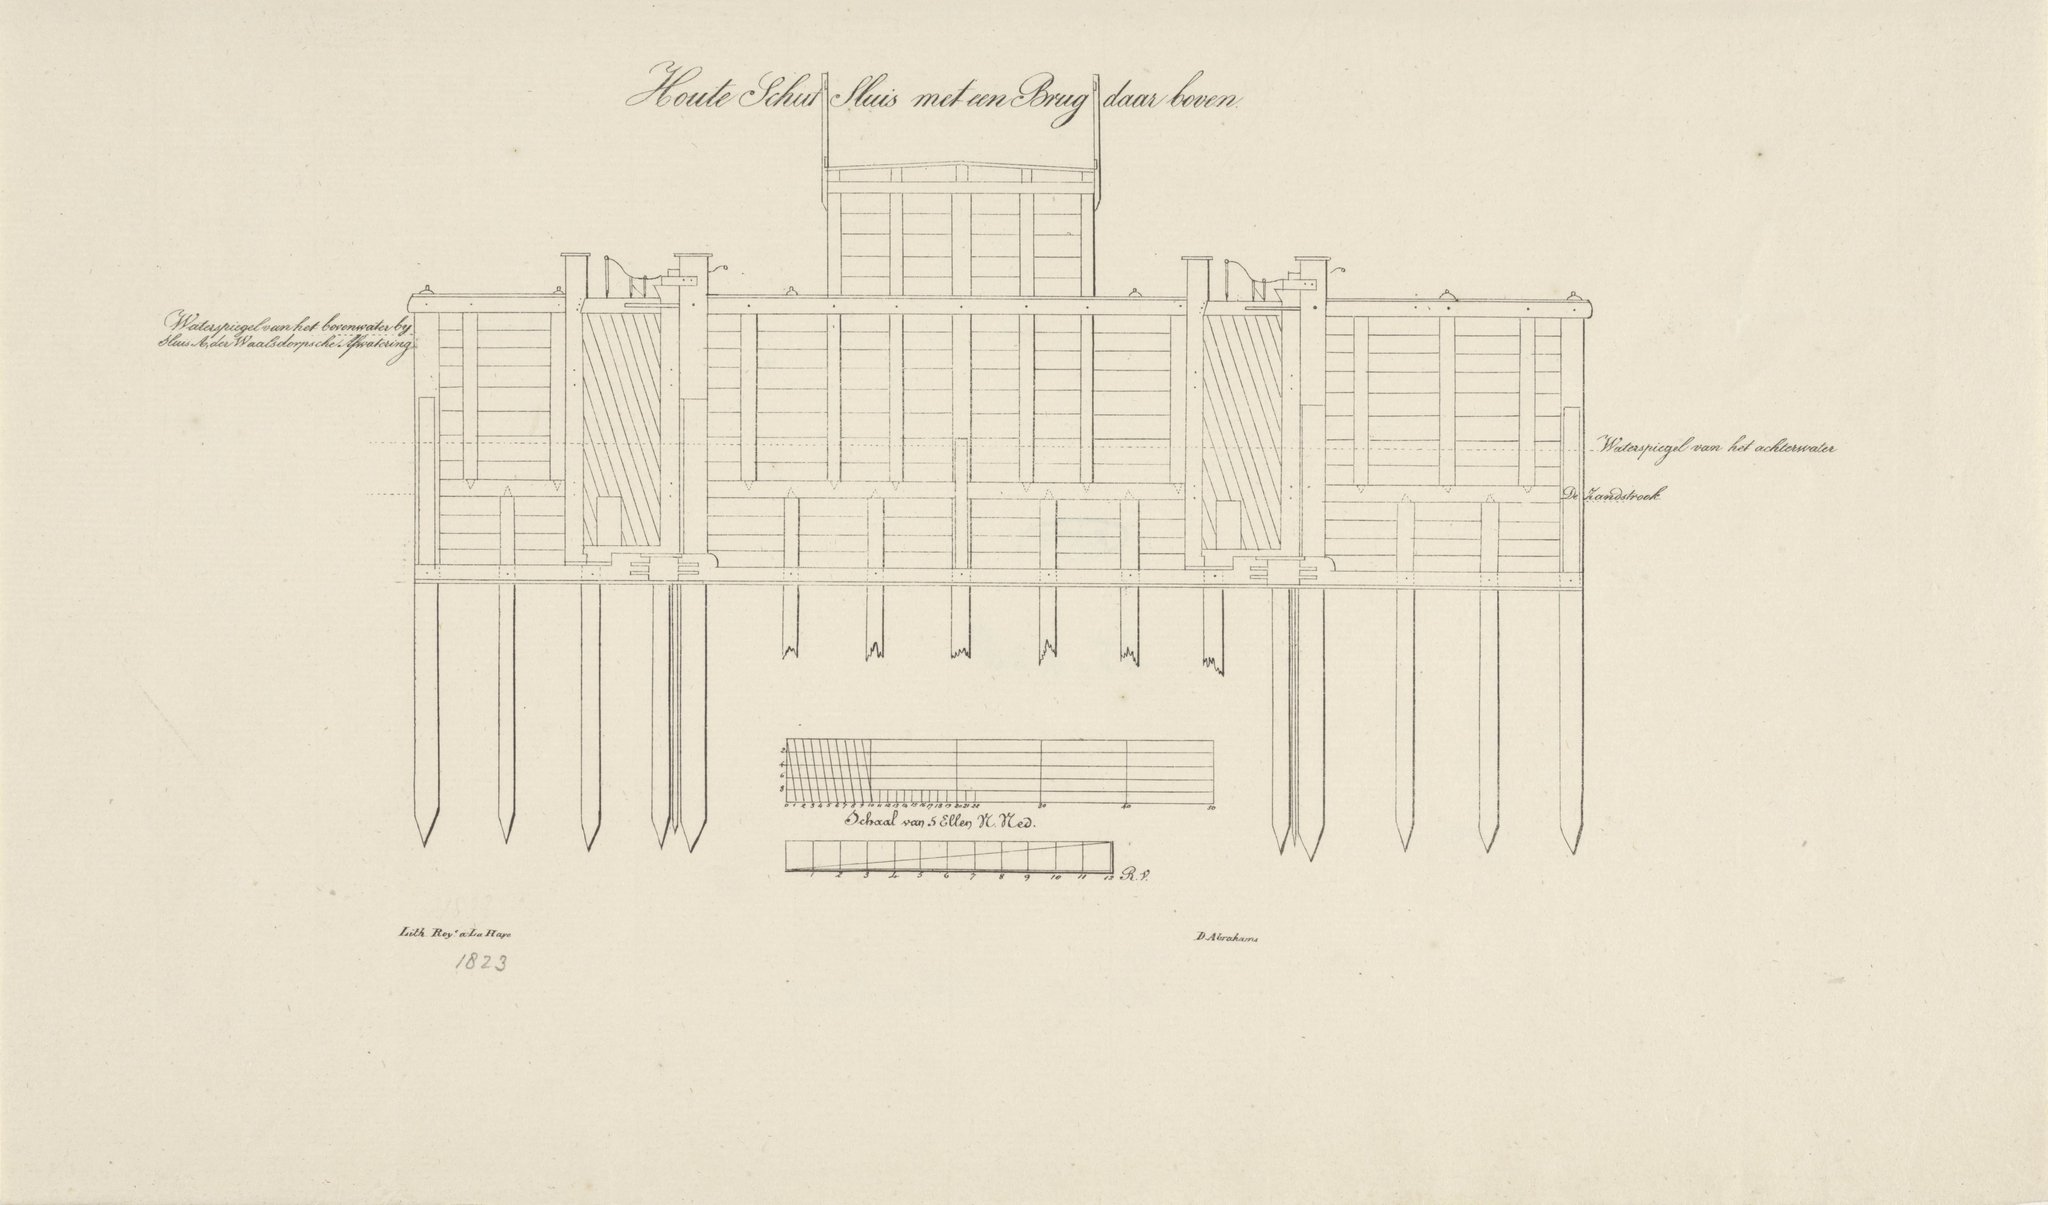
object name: print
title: Ontwerp voor een schutsluis bij Waalsdorp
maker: daniël abrahams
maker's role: print maker, printer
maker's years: 1795-1854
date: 1820-1825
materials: paper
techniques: pen lithography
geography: the hague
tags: sluice, weir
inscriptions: name: ‘Daniël Abrahams’, collector's mark: Lugt 2760, collector's mark: Lugt 2228, date: ‘1823’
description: Ontwerp voor een houten schutsluis met brug naar boven. Eronder een schaalindicatie van vijf ellen.